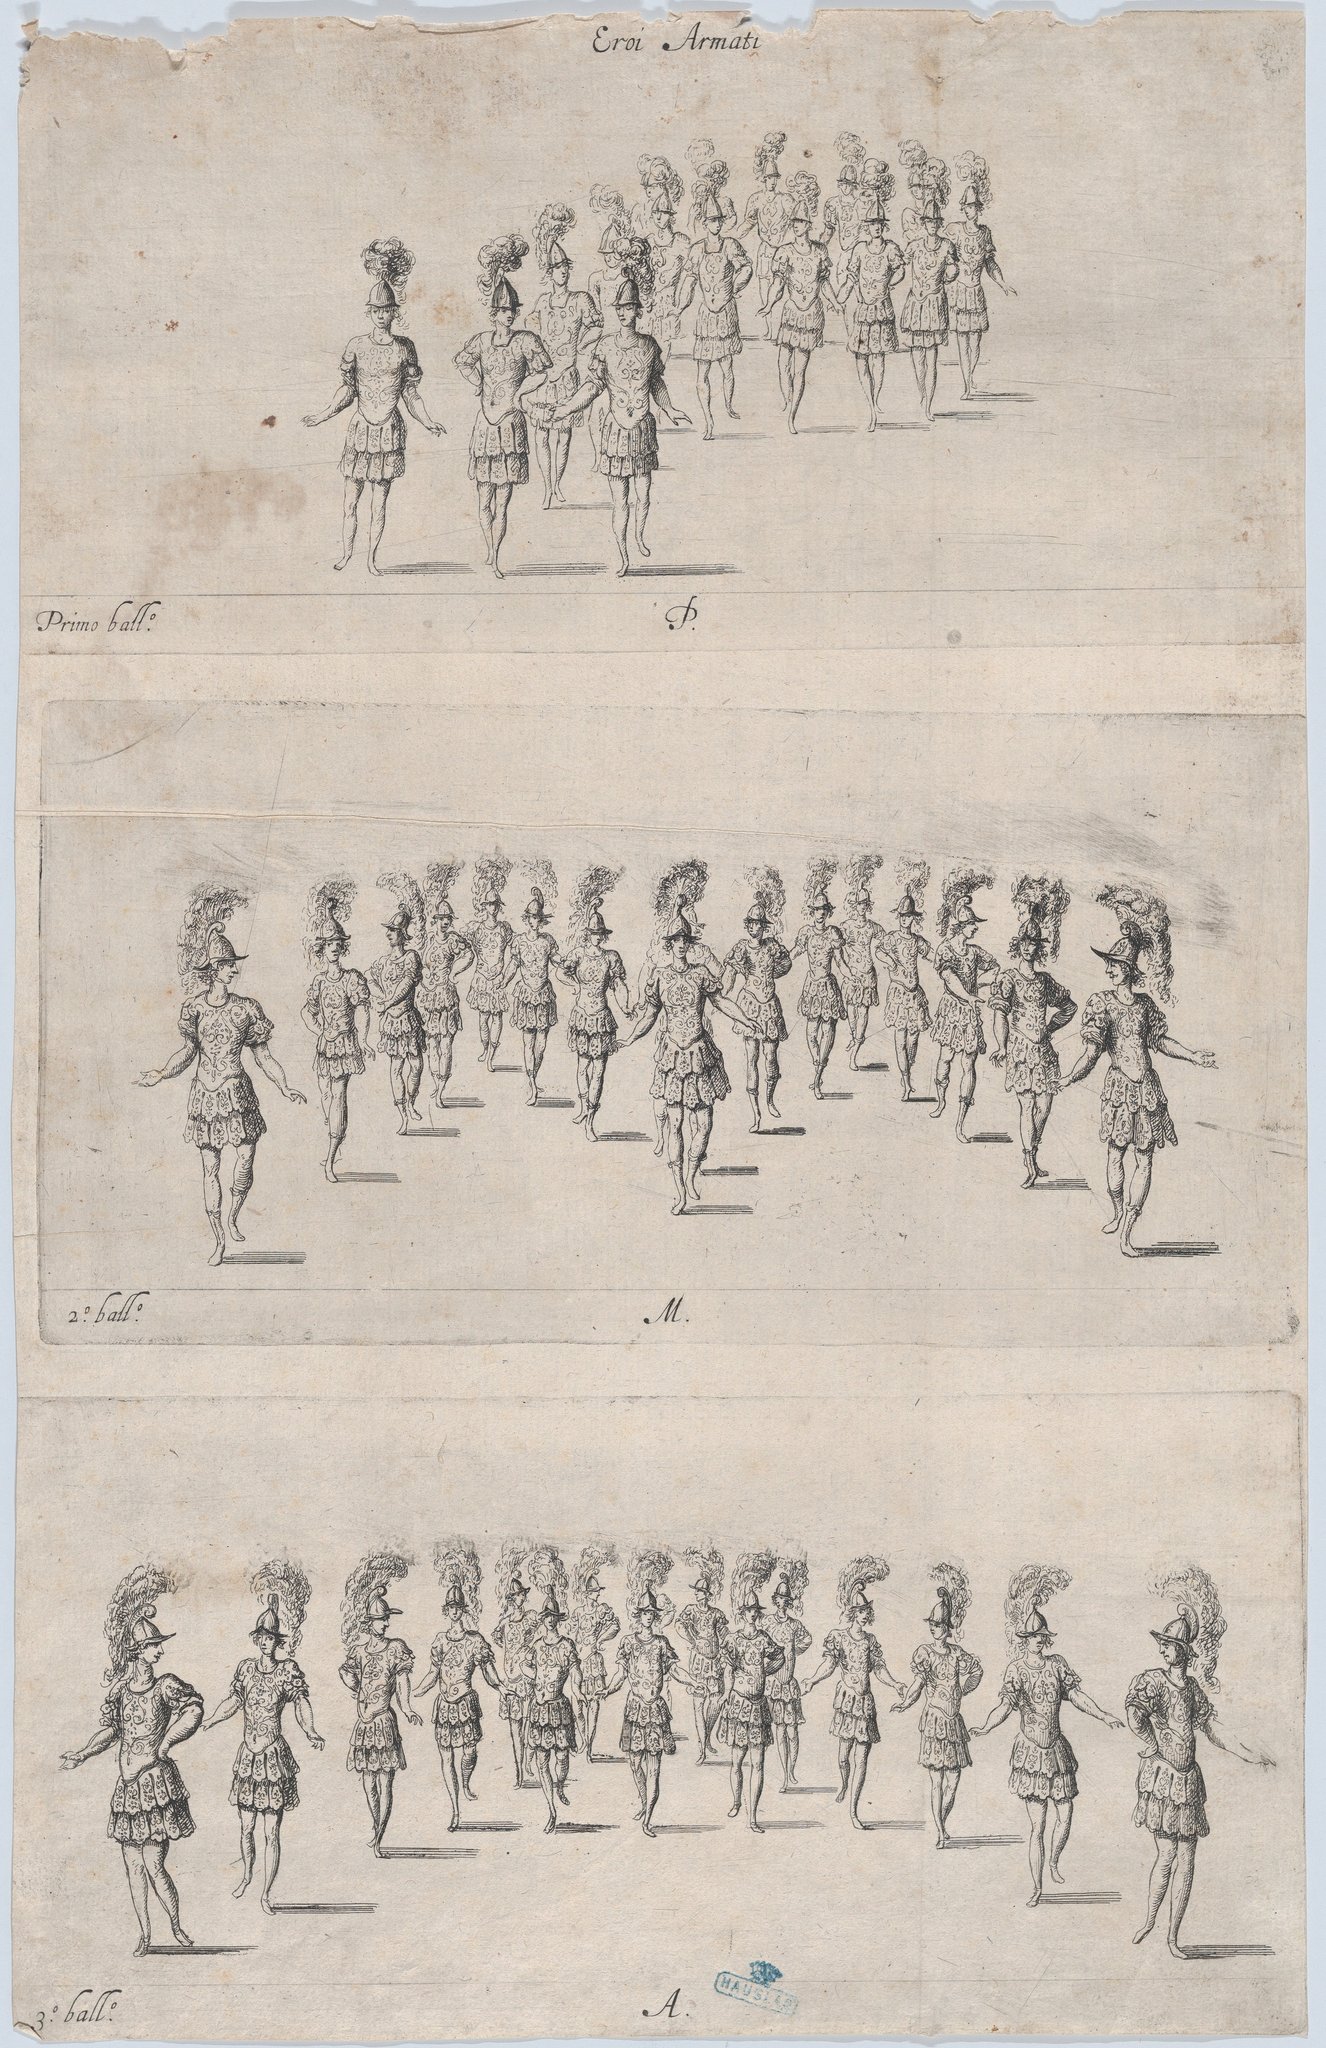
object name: print, fete, ornament architecture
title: Armed heroes performing ballets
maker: anonymous, italian, 17th century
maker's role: artist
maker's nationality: italian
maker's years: 1600-1700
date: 1601-1700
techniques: etching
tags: human figures,soldiers,dancing